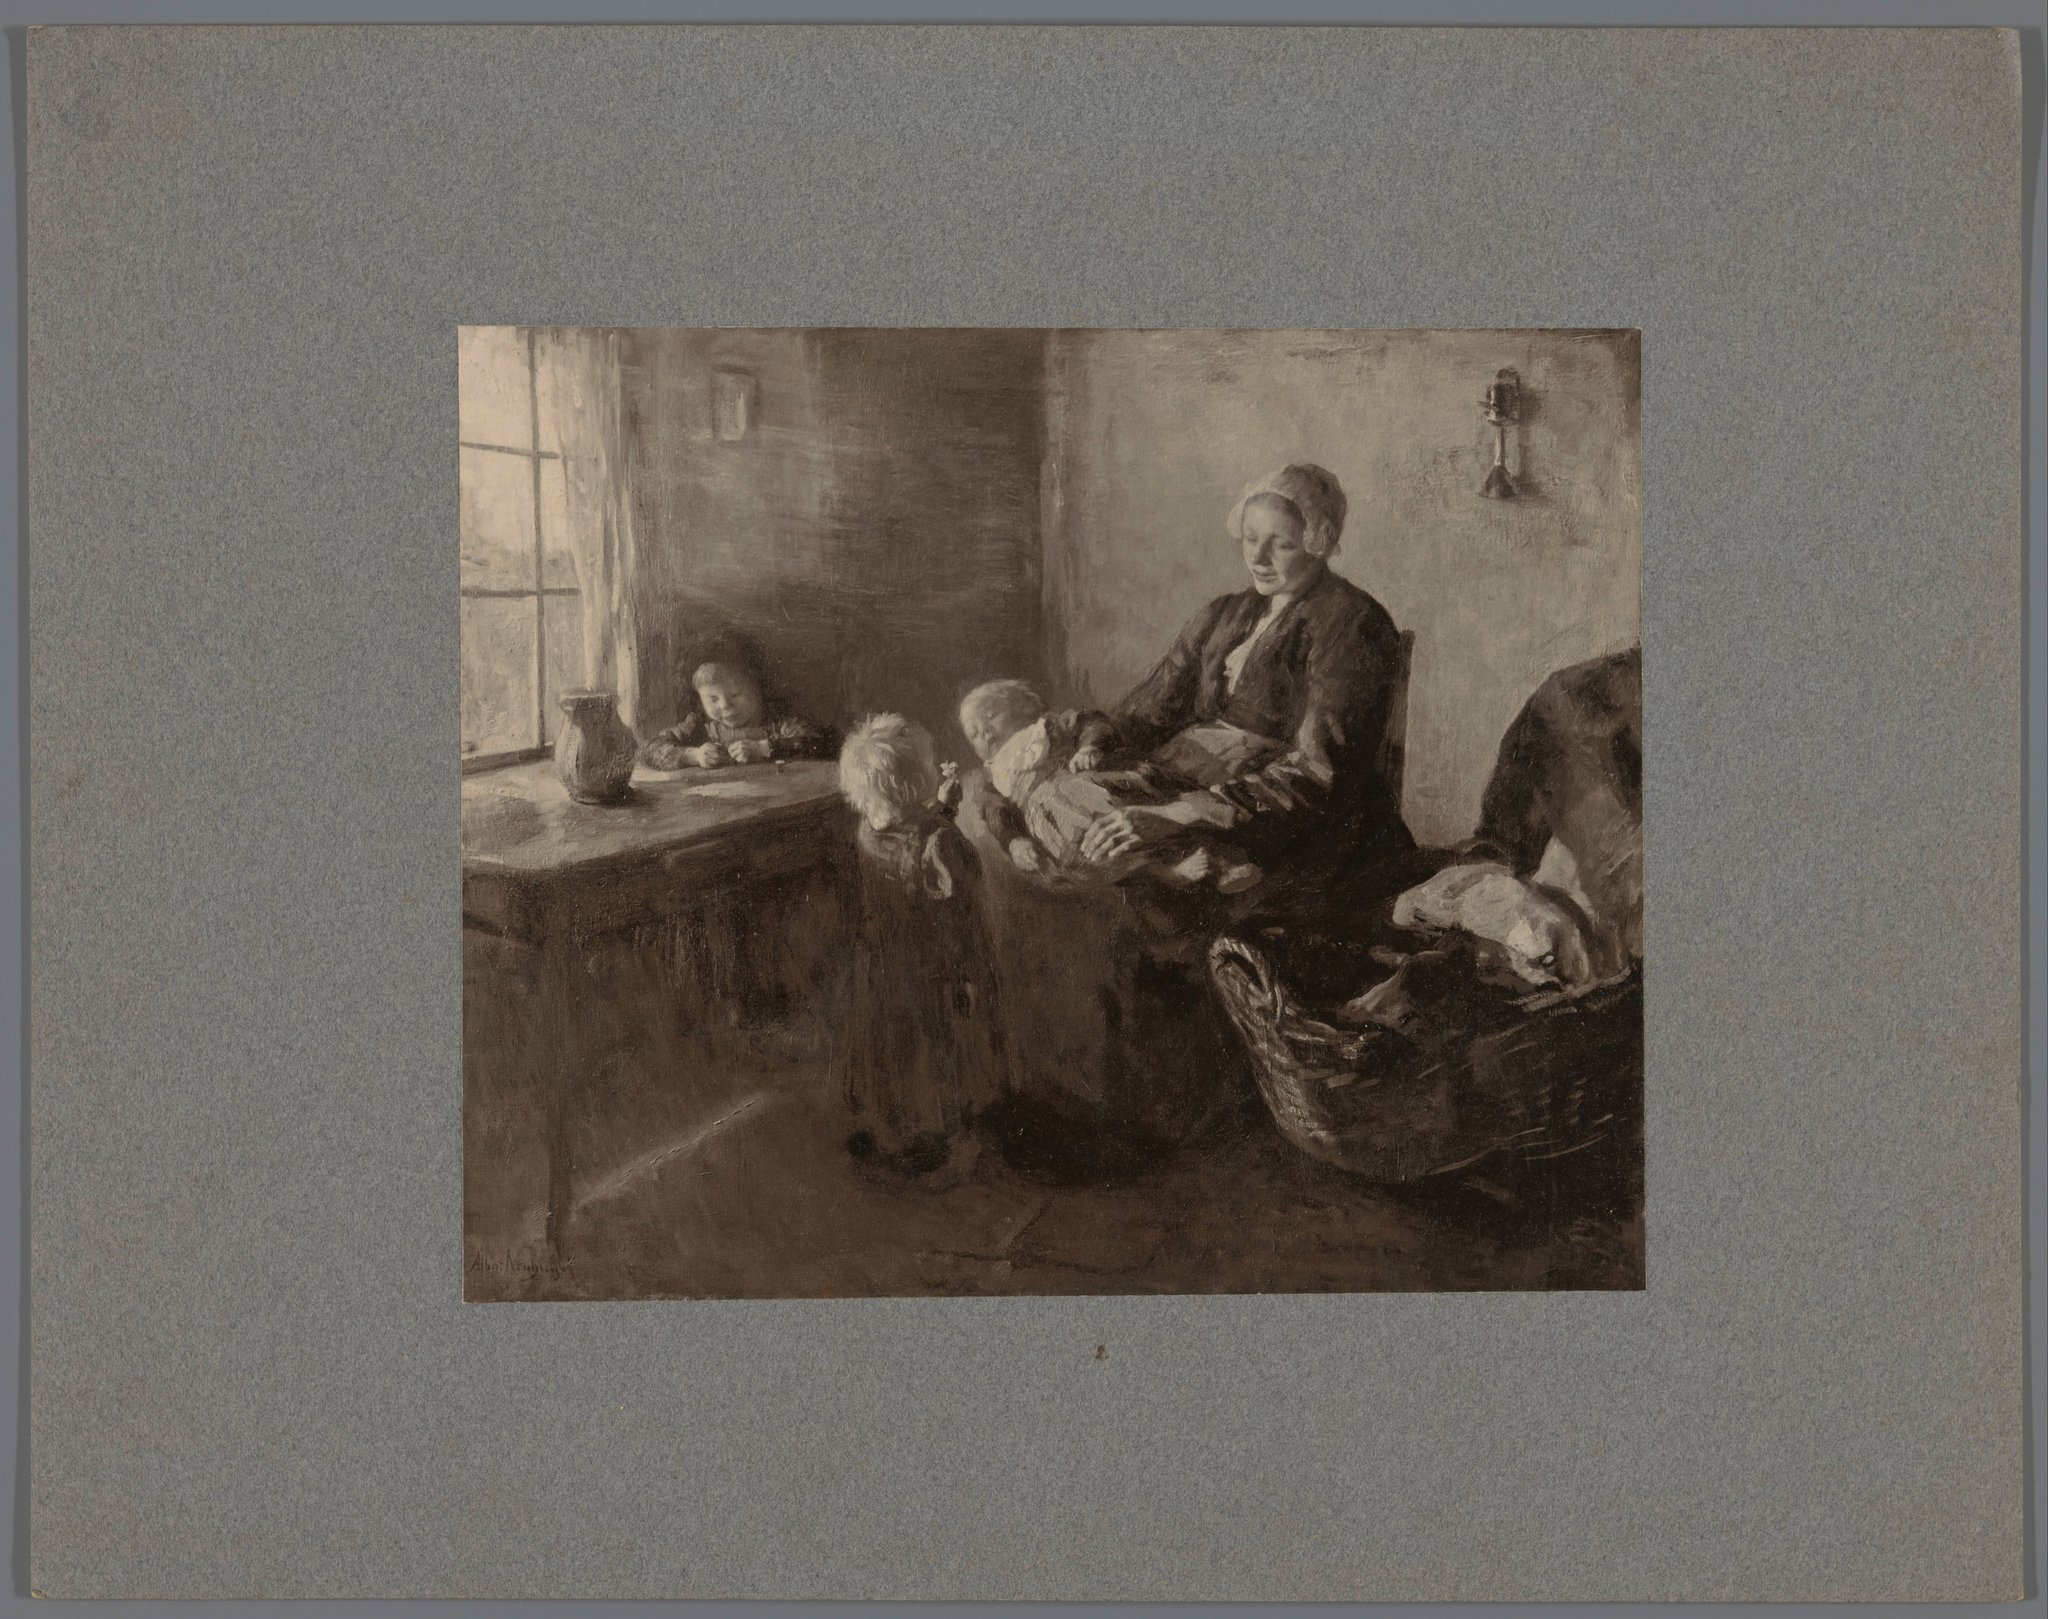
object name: photograph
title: Fotoreproductie van schilderij door Albert Neuhuys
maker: Anonymous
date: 1850-1900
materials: cardboard, photographic support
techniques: albumen print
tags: adult woman, child, infant, baby